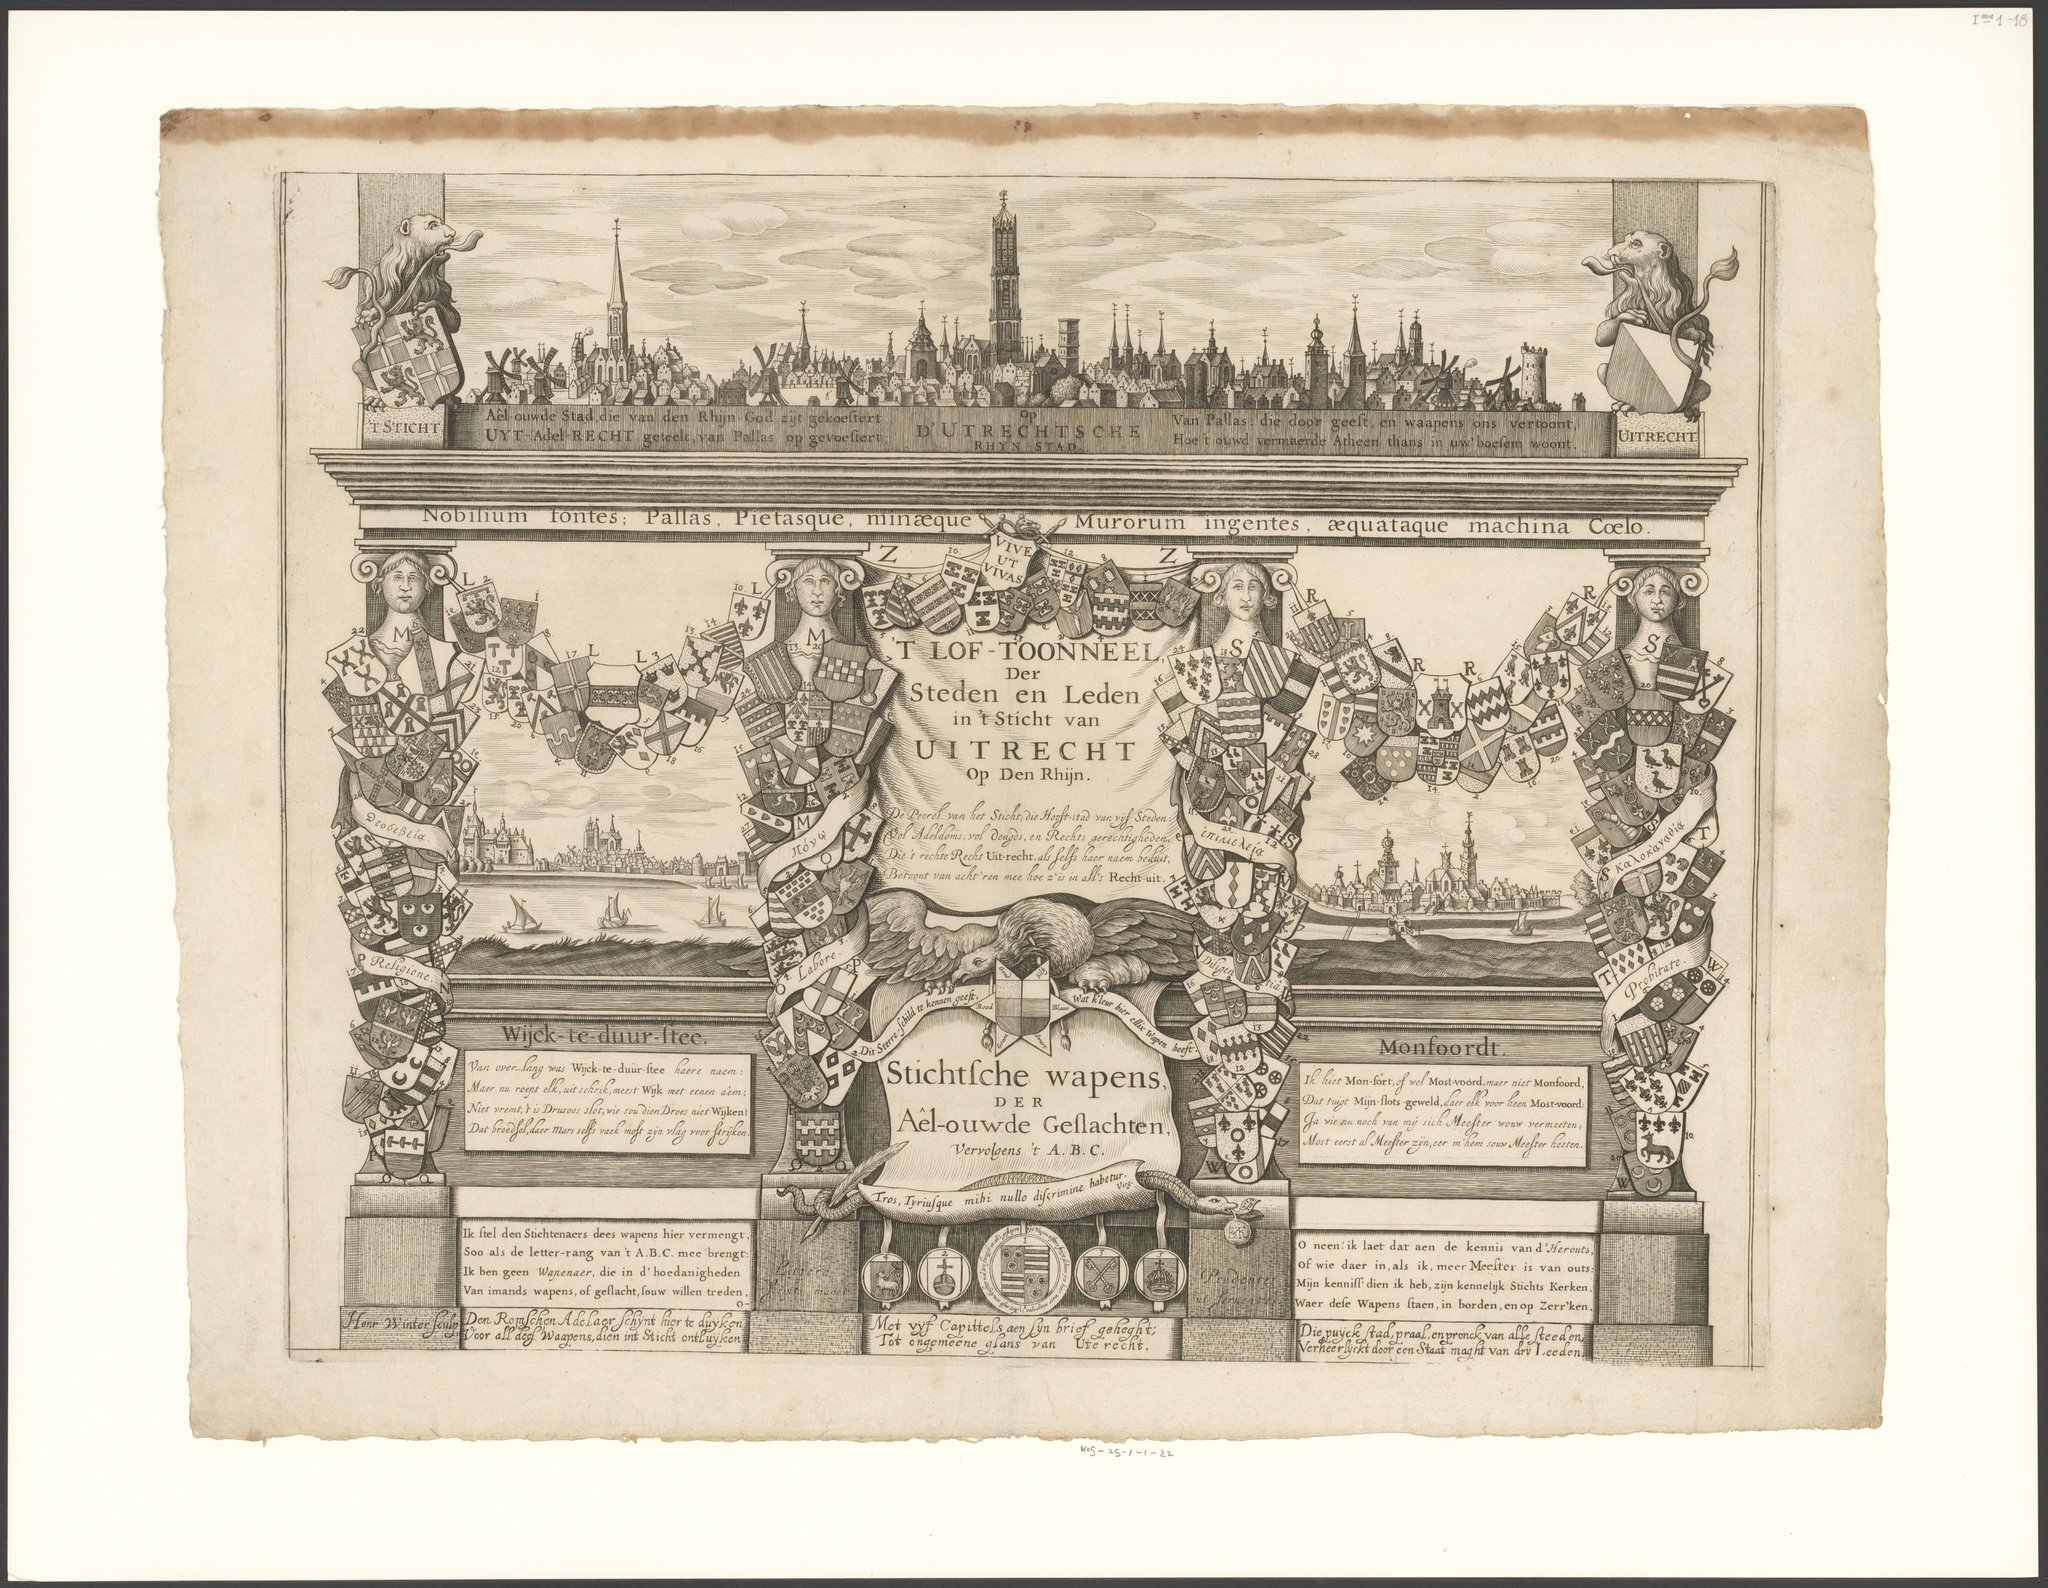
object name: print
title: Wapenkaart van Utrecht (onderste deel)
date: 1663-1732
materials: paper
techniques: engraving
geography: utrecht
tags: coat of arms (as symbol of the state, etc.), prospect of city, town panorama, silhouette of city, wijk bij duurstede, utrecht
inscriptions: collector's mark, collector's mark: Lugt 1641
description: Bovenste deel van deze prent ontbreekt. Prent gebruikt in: Wapenen der Steden & Oud Adelycke Geslachten in de Landen van Holland, Zeeland, Utrecht en Overyssel. S.l.: s.n., s.a. [ca. 1717]. Alle wapens zijn voorzien van een nummer, maar de legenda ontbreekt hier. Deze werd waarschijnlijk vanaf de eerste uitgave los gedrukt en kon aan weerszijden van de platen worden geplakt. Van de legenda zijn drukken uit 1717 en 1732 bekend, beide uitgegeven door Johannes Kanneman te Utrecht.